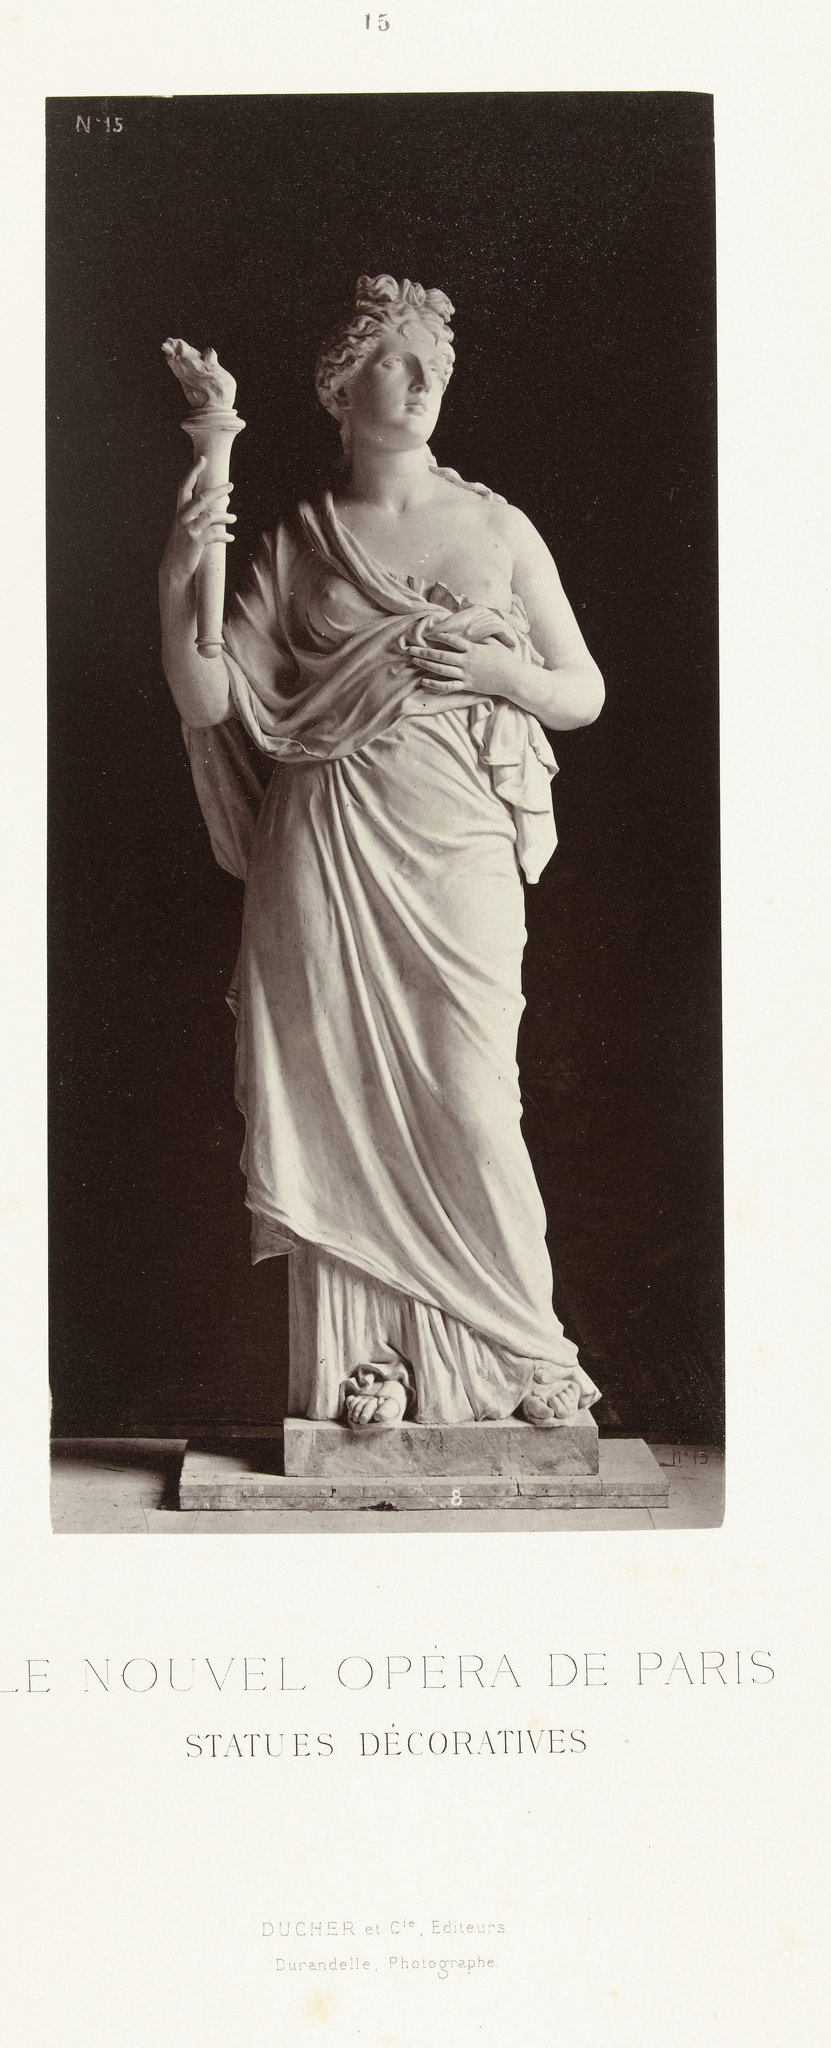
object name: photograph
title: Le Nouvel Opéra de Paris met 50 foto's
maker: louis-emile durandelle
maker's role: fotograaf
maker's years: 1839-1917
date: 1878-1881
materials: photographic support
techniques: albumen print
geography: paris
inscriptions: number: ‘15’, number: ‘8’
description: bij boek in Bibliotheek RMA, Zie Frizot, pp. 217-223, vgl G. Vicaire, Manuel de l'amateur de livres du XIXe siècle, vol. 3, column 870.